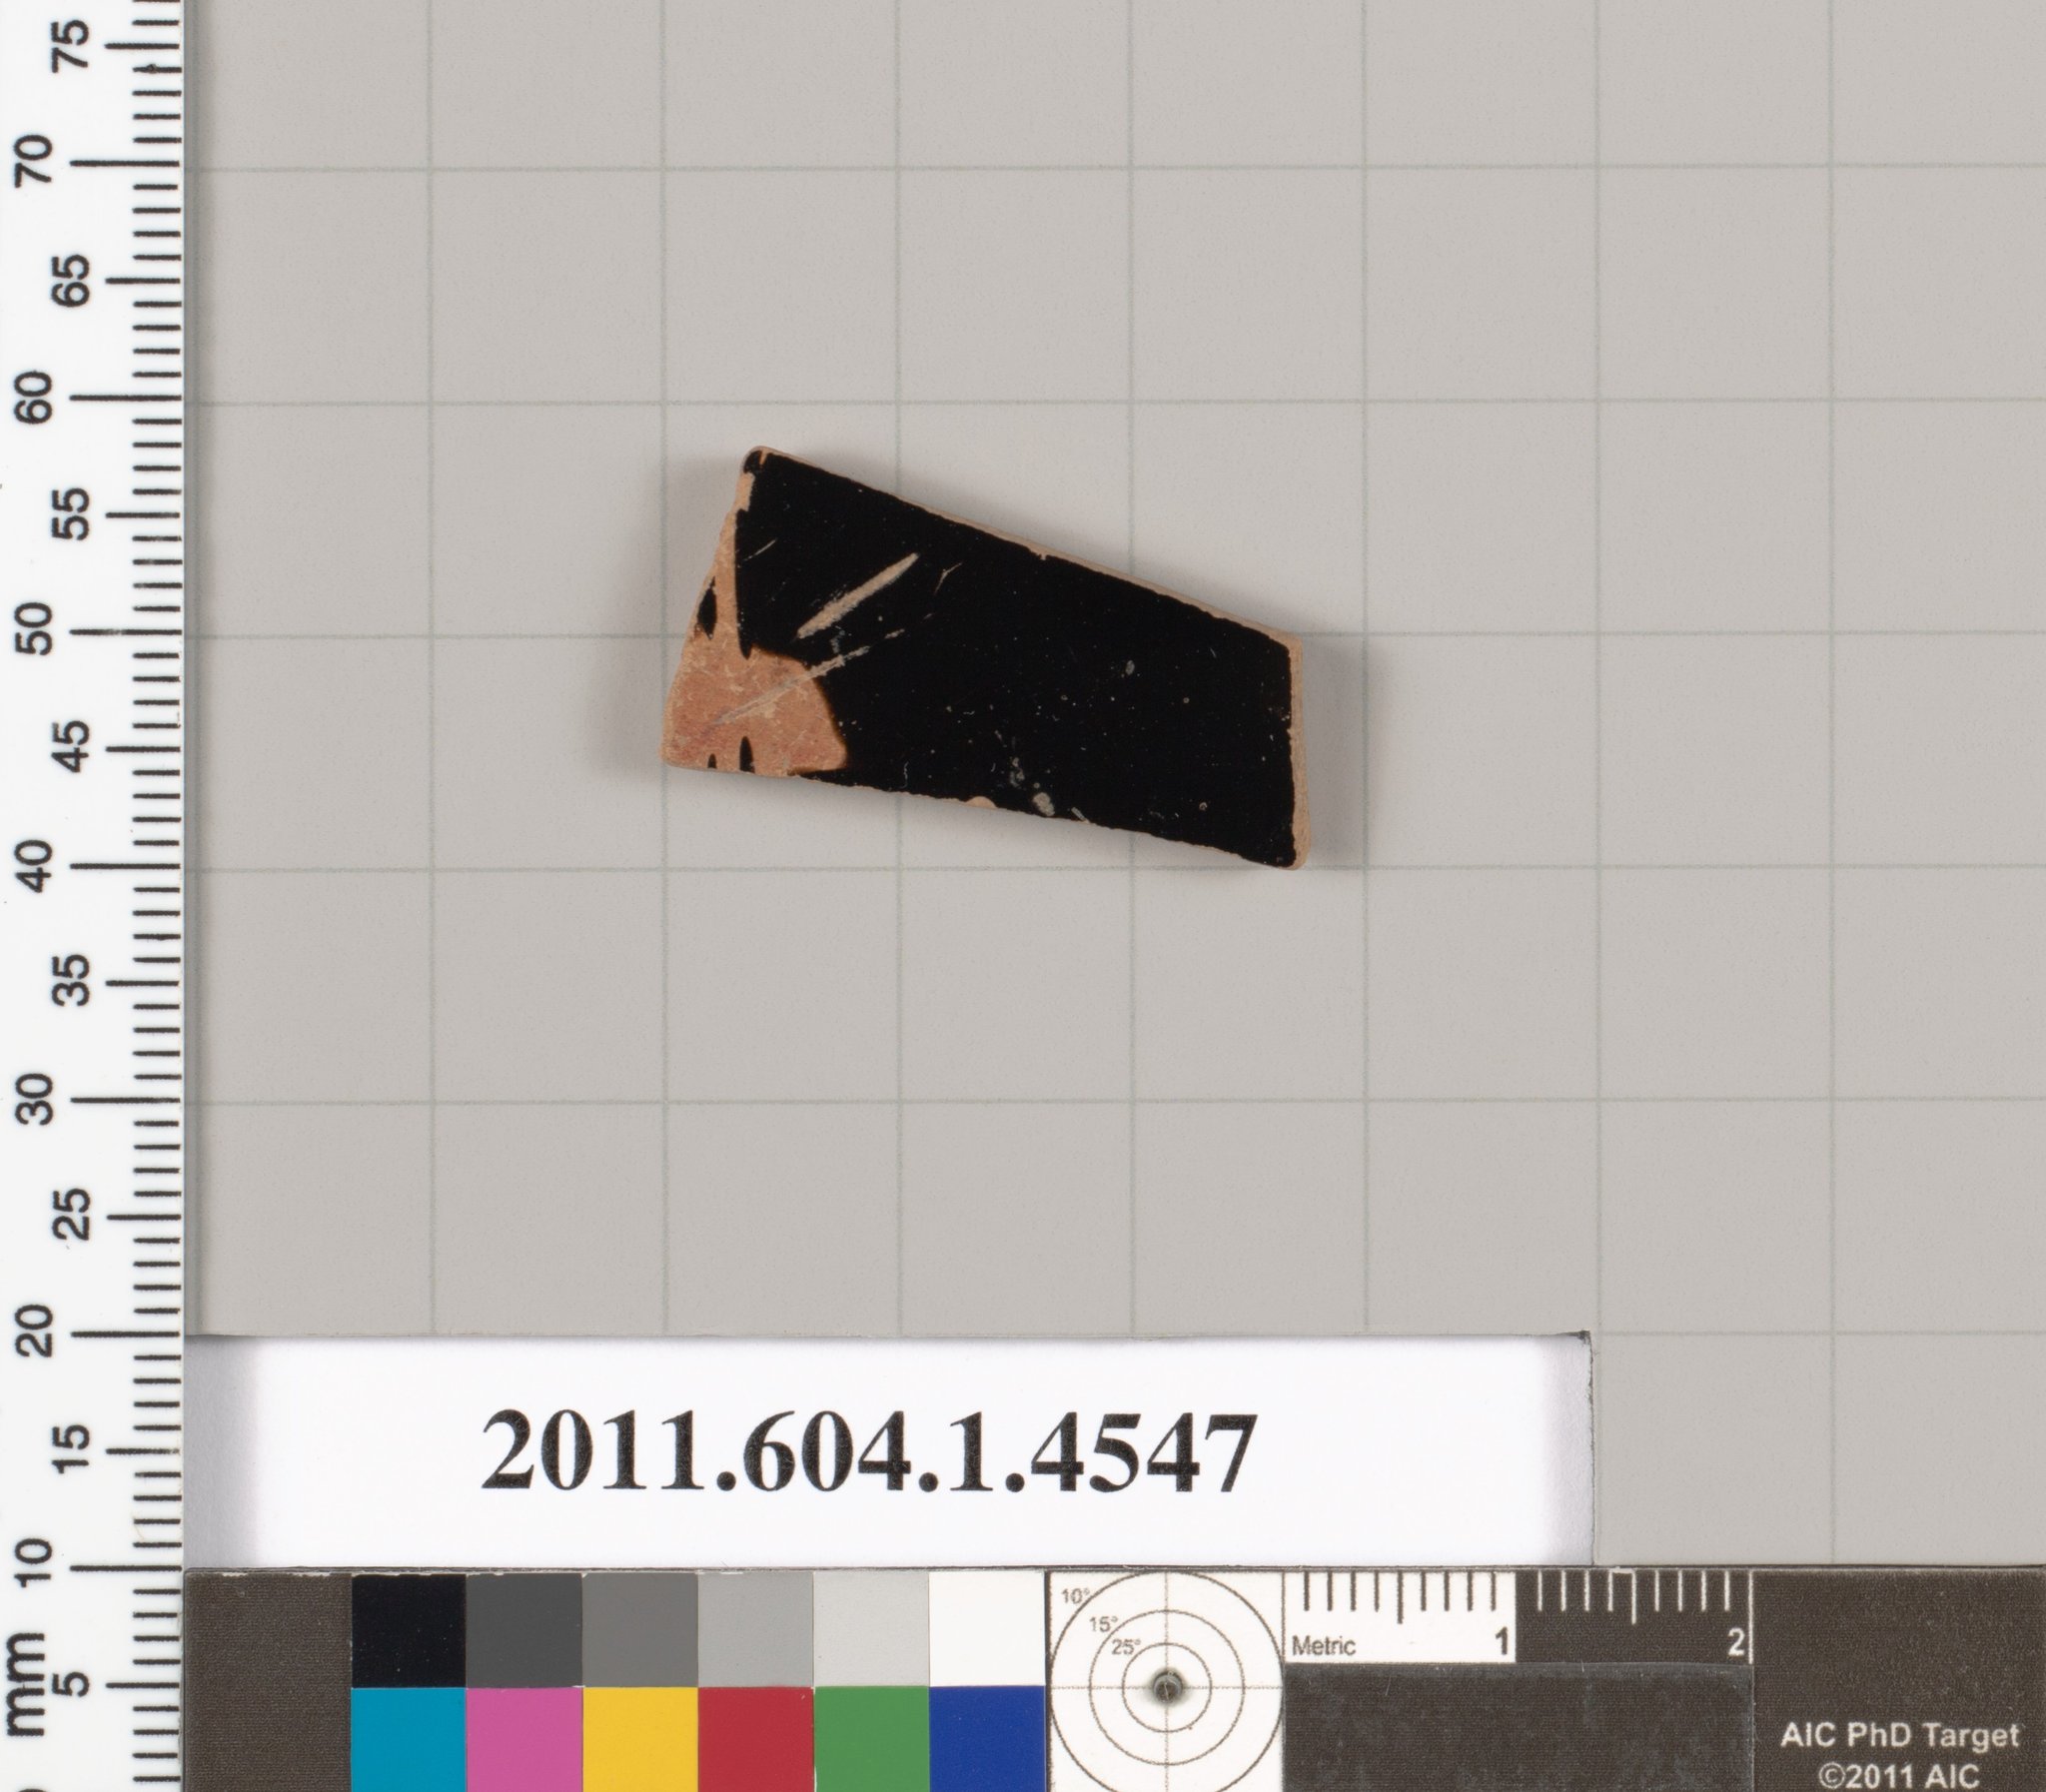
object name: kylix fragment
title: Terracotta fragment of a kylix (drinking cup)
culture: greek, attic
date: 475-451 BCE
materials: terracotta